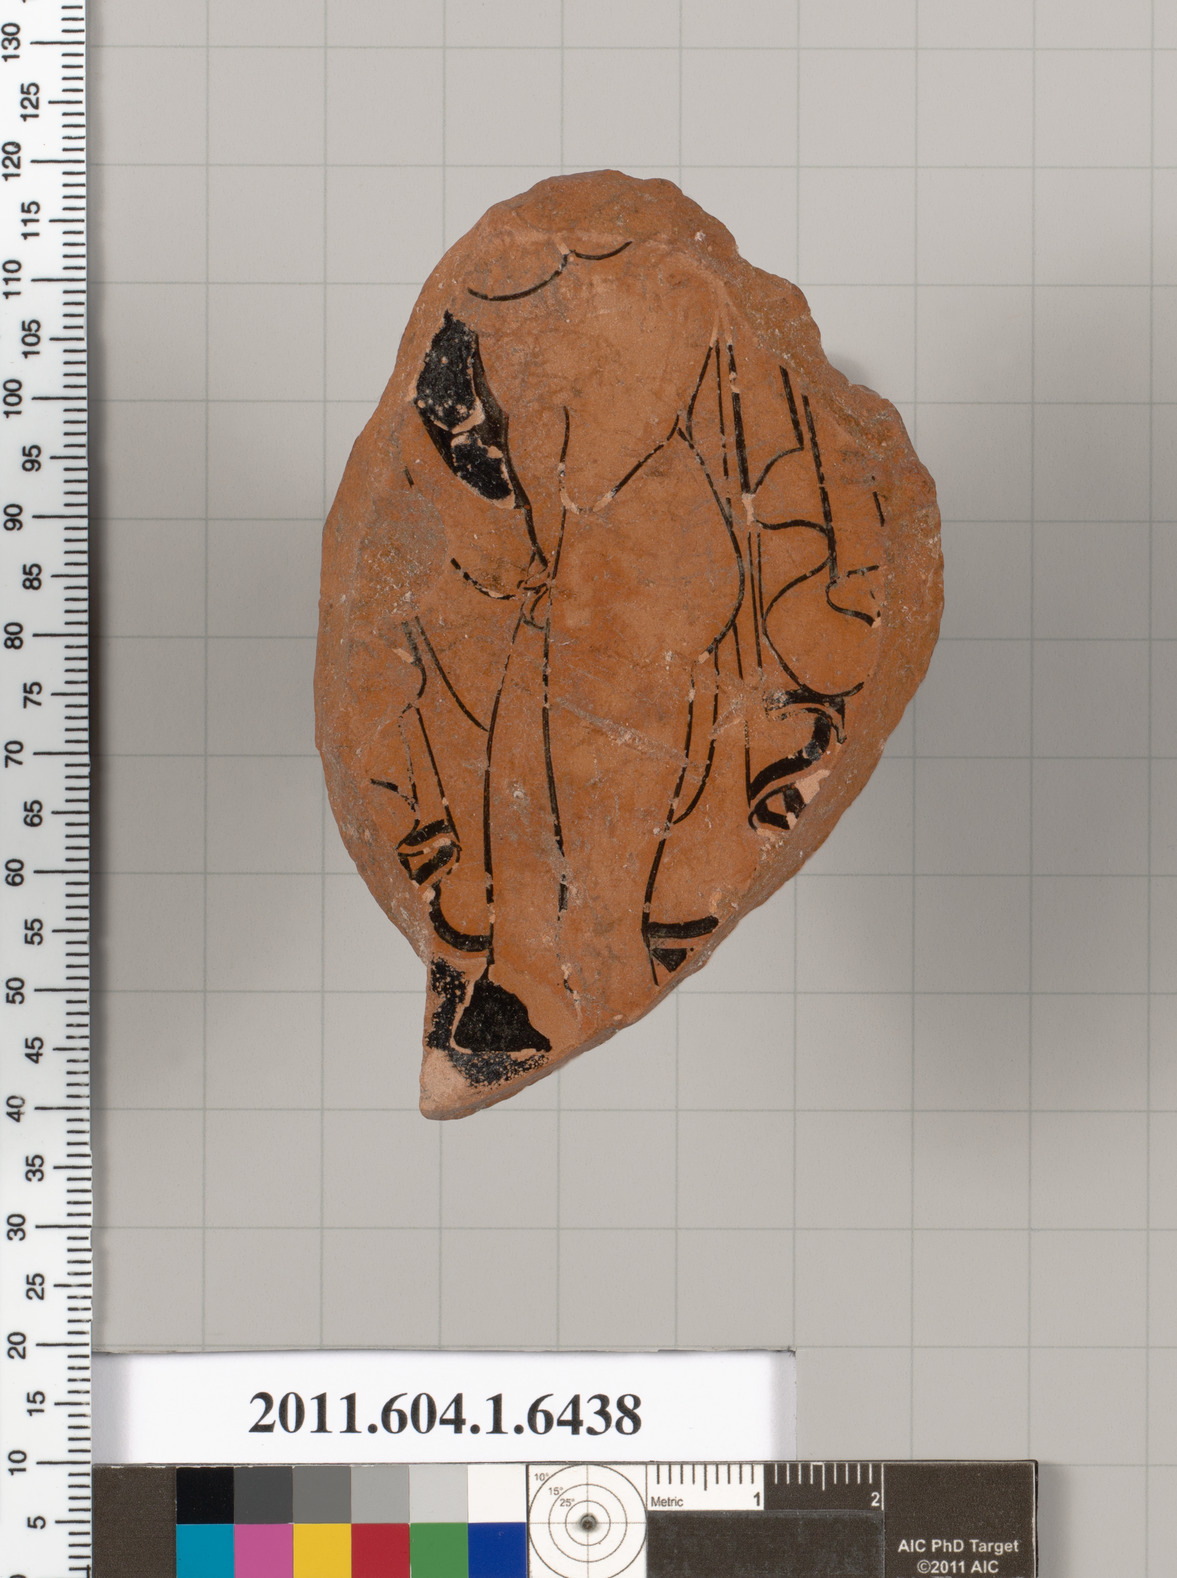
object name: kylix fragment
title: Terracotta fragment of a kylix (drinking cup)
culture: greek, attic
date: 490-480 BCE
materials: terracotta